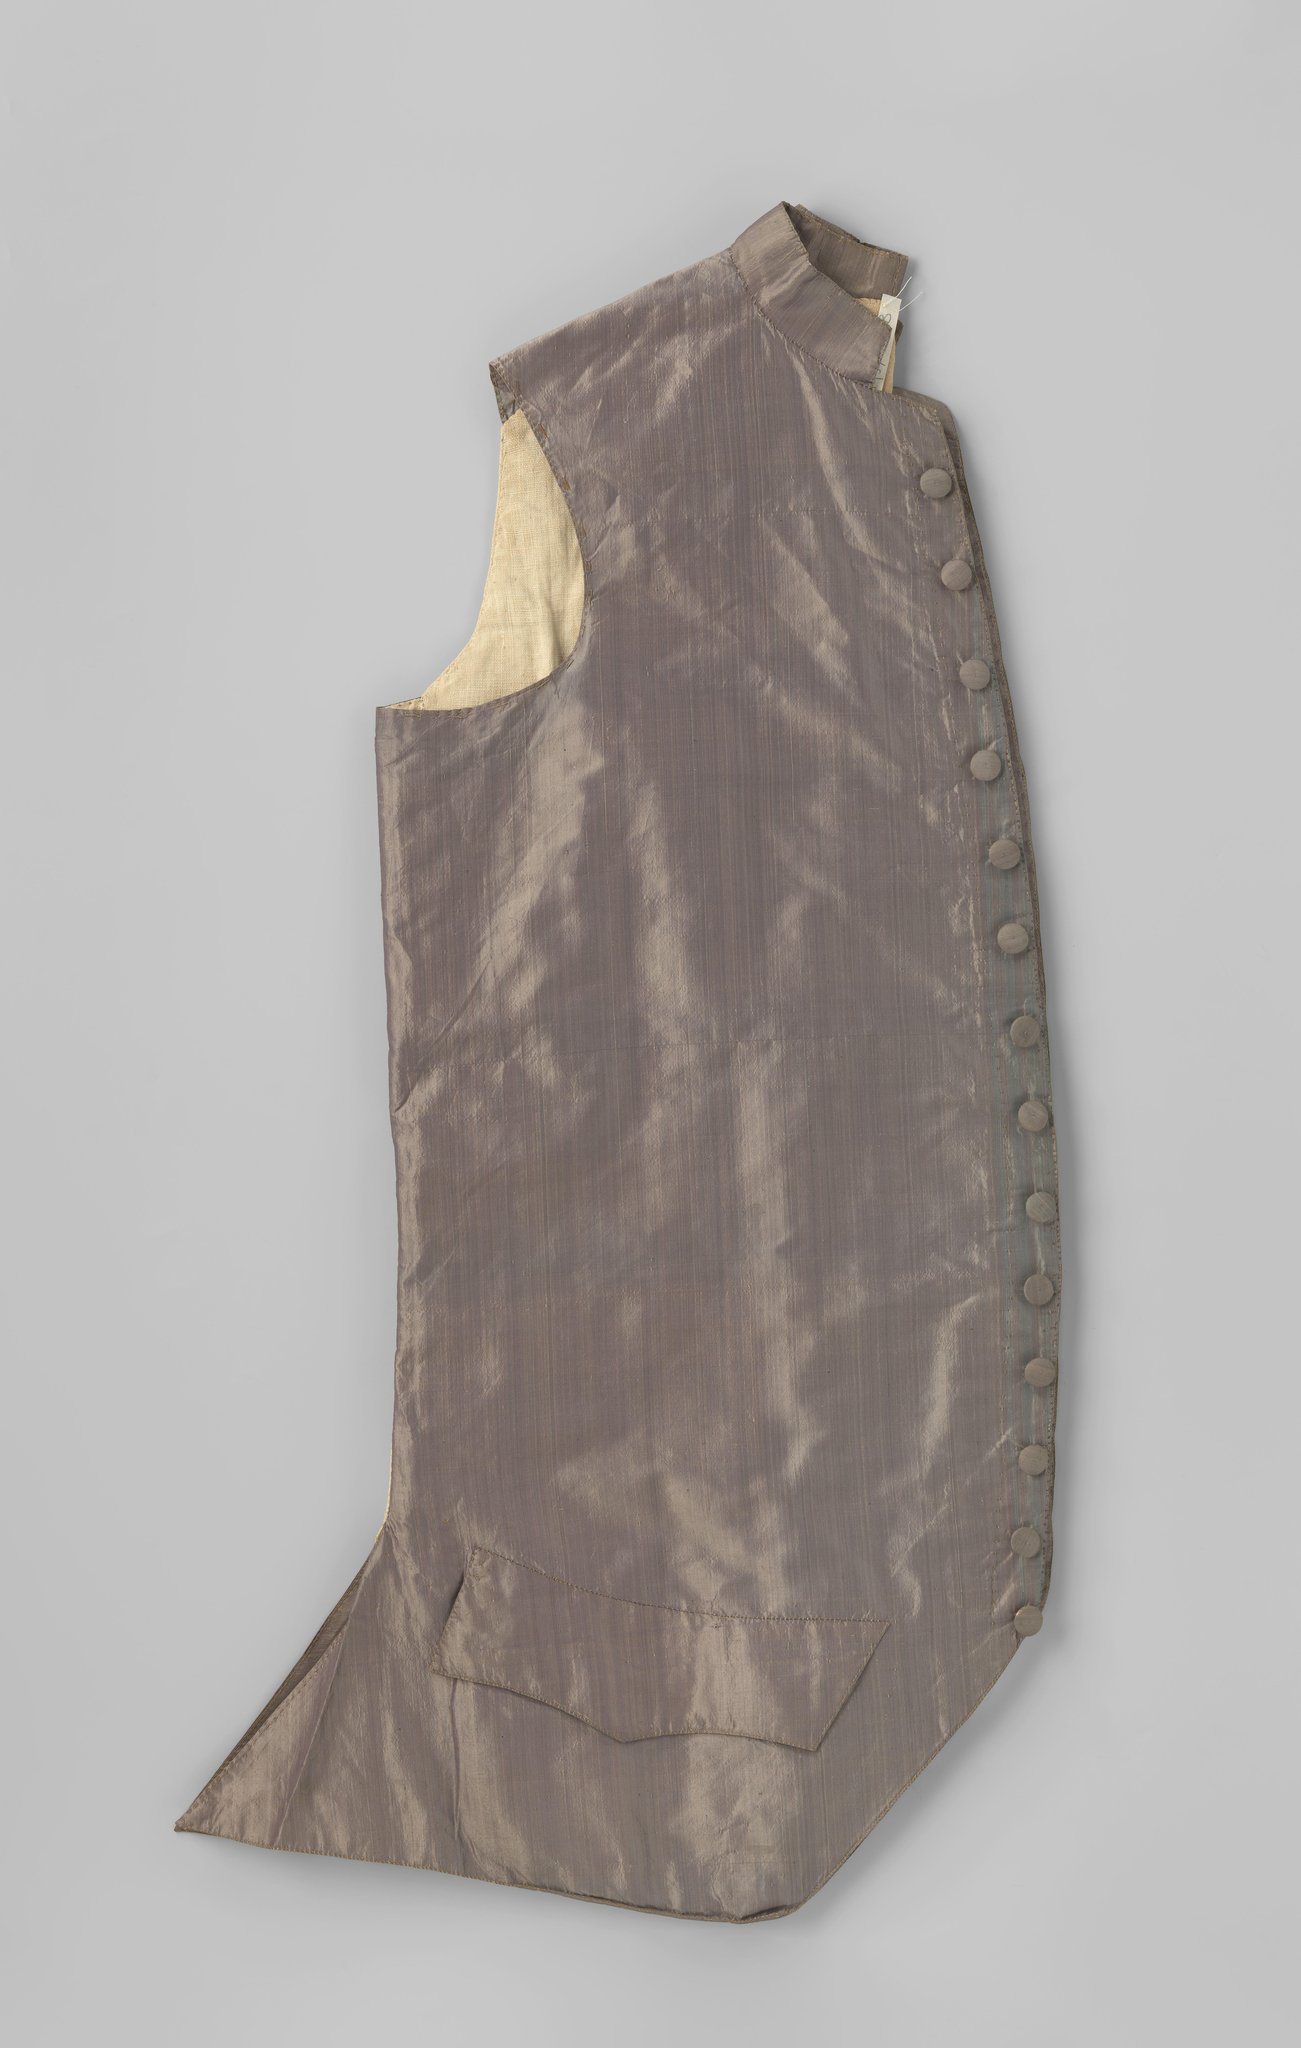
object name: menswear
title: Lang, mouwloos mannenvest van mauve-grijze changeant tafzijde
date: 1760-1780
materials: linen, silk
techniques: weave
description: Lang, mouwloos mannenvest van mauve-grijze changeant tafzijde, met hoekig weggesneden voorpanden, opstaand boord, twee steekzakken, rugpand van wit linnen en langs de voorpanden voorzien van 14 stofknopen met gele knoopsgaten. Gevoerd met dito changeant tafzijde.